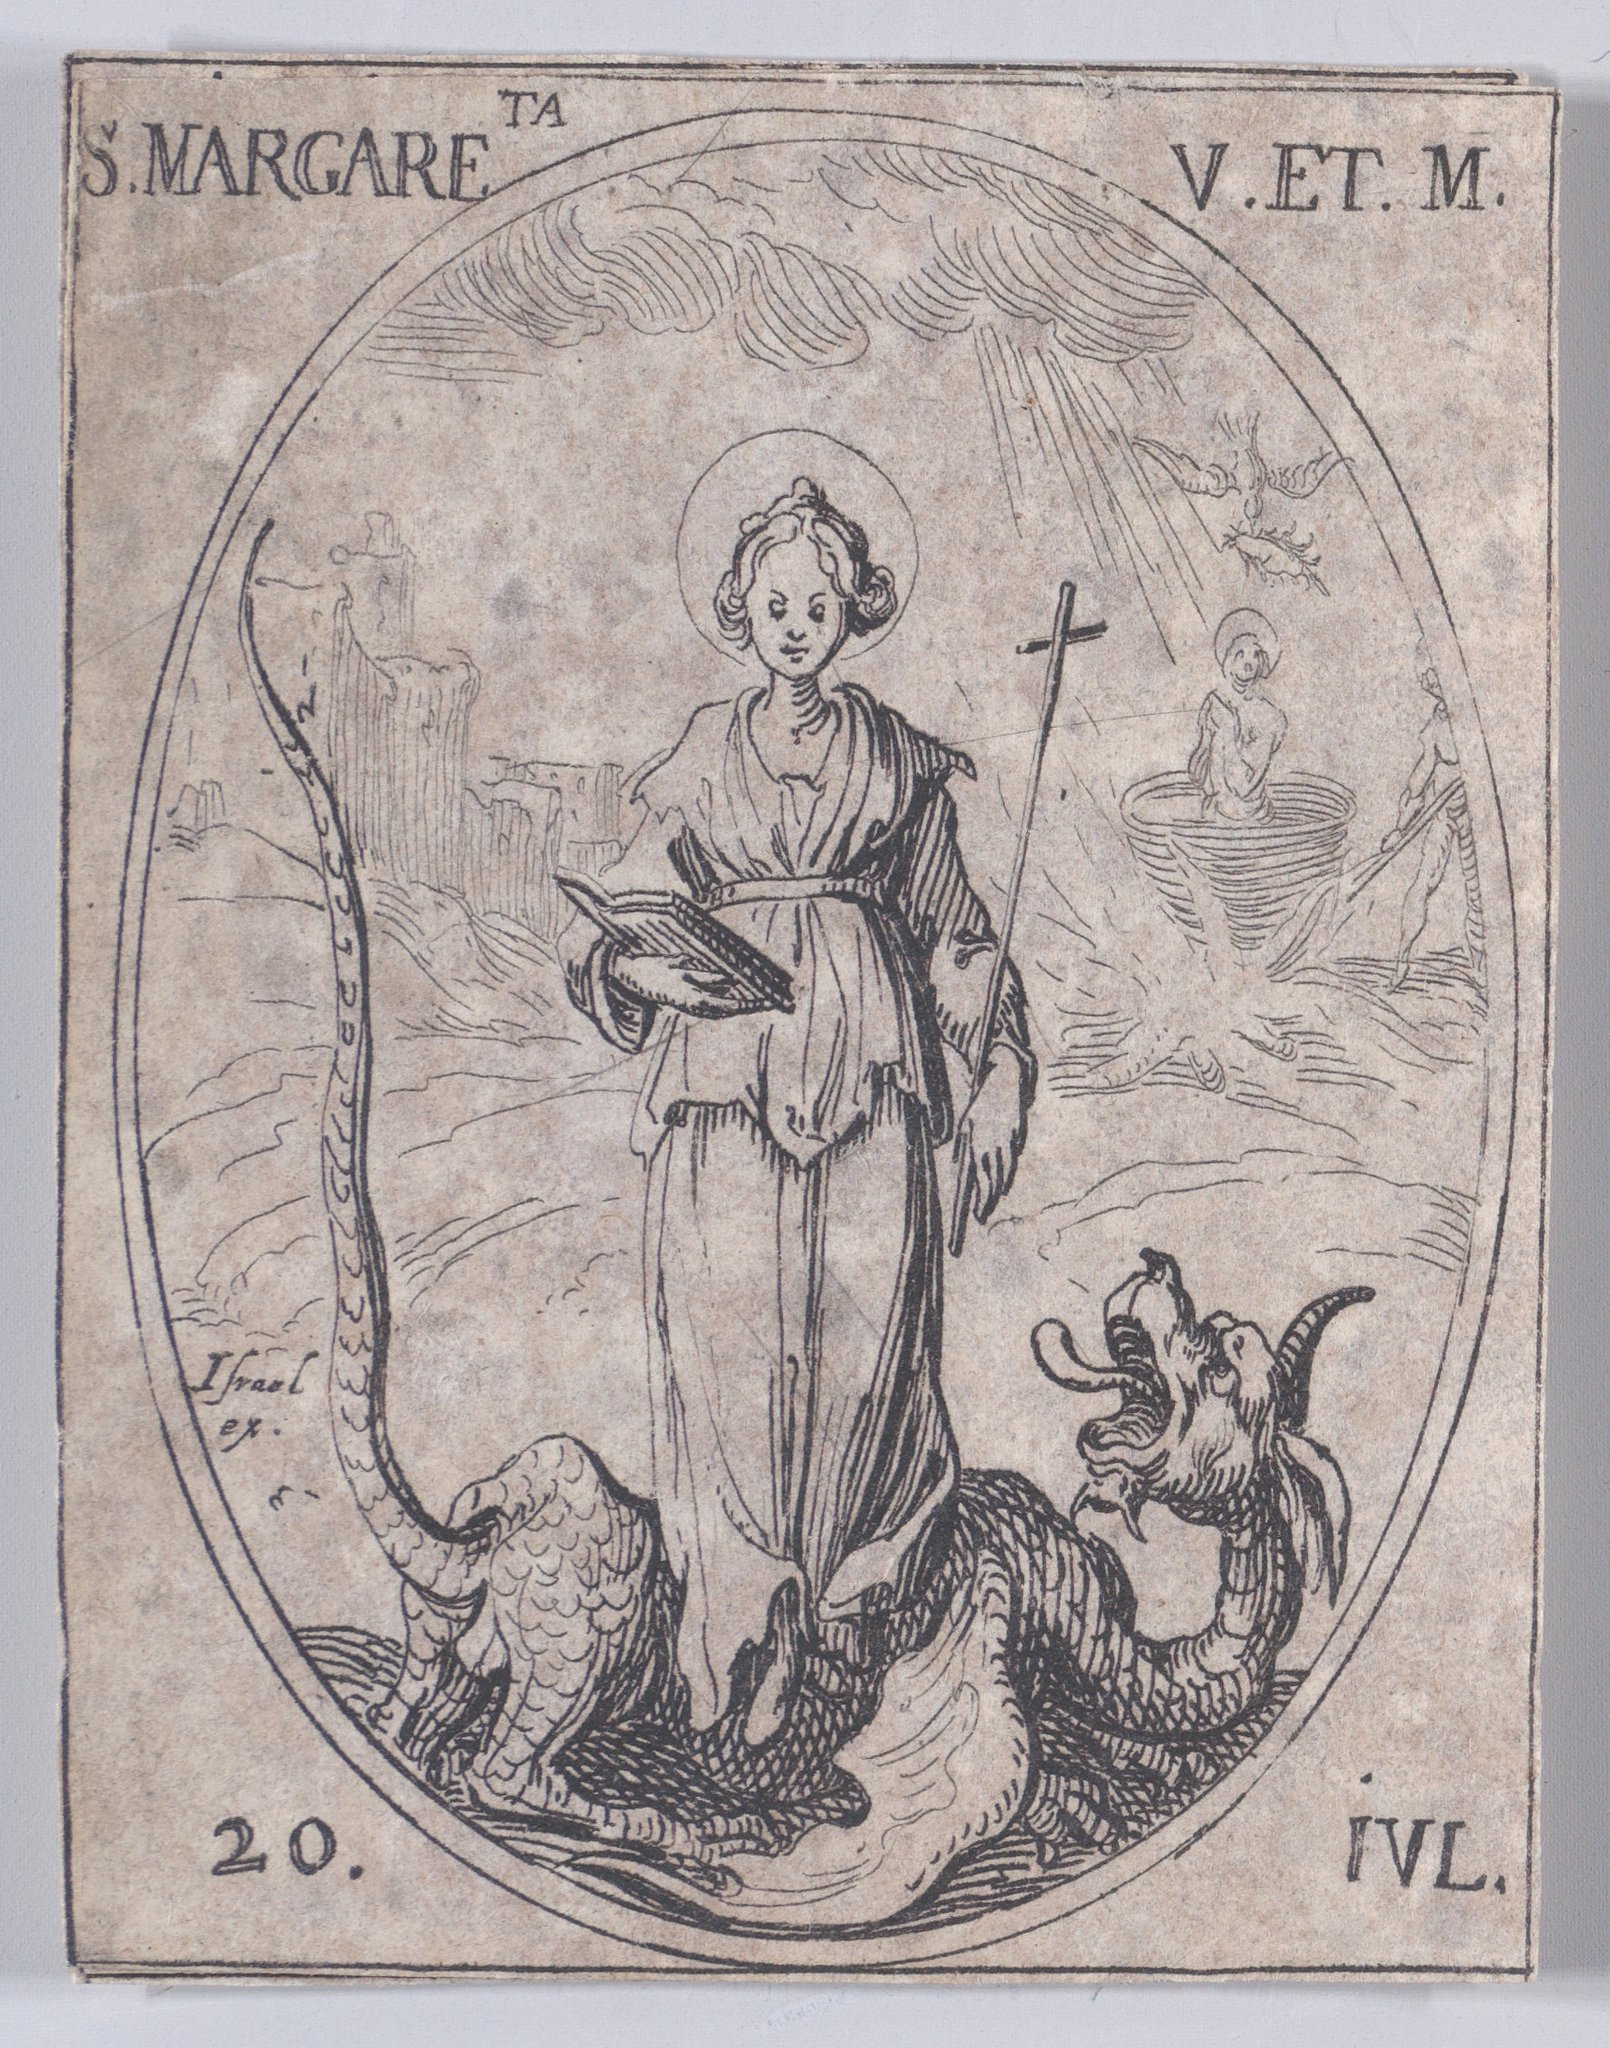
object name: print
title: Ste. Marguerite, vierge et martyre (St. Margaret of Antioch, Virgin and Martyr), July 20th, from "Les Images De Tous Les Saincts et Saintes de L'Année" (Images of All of the Saints and Religious Events of the Year)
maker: jacques callot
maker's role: artist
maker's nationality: french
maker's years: 1592-1635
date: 1636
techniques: etching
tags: women,dragons,saints